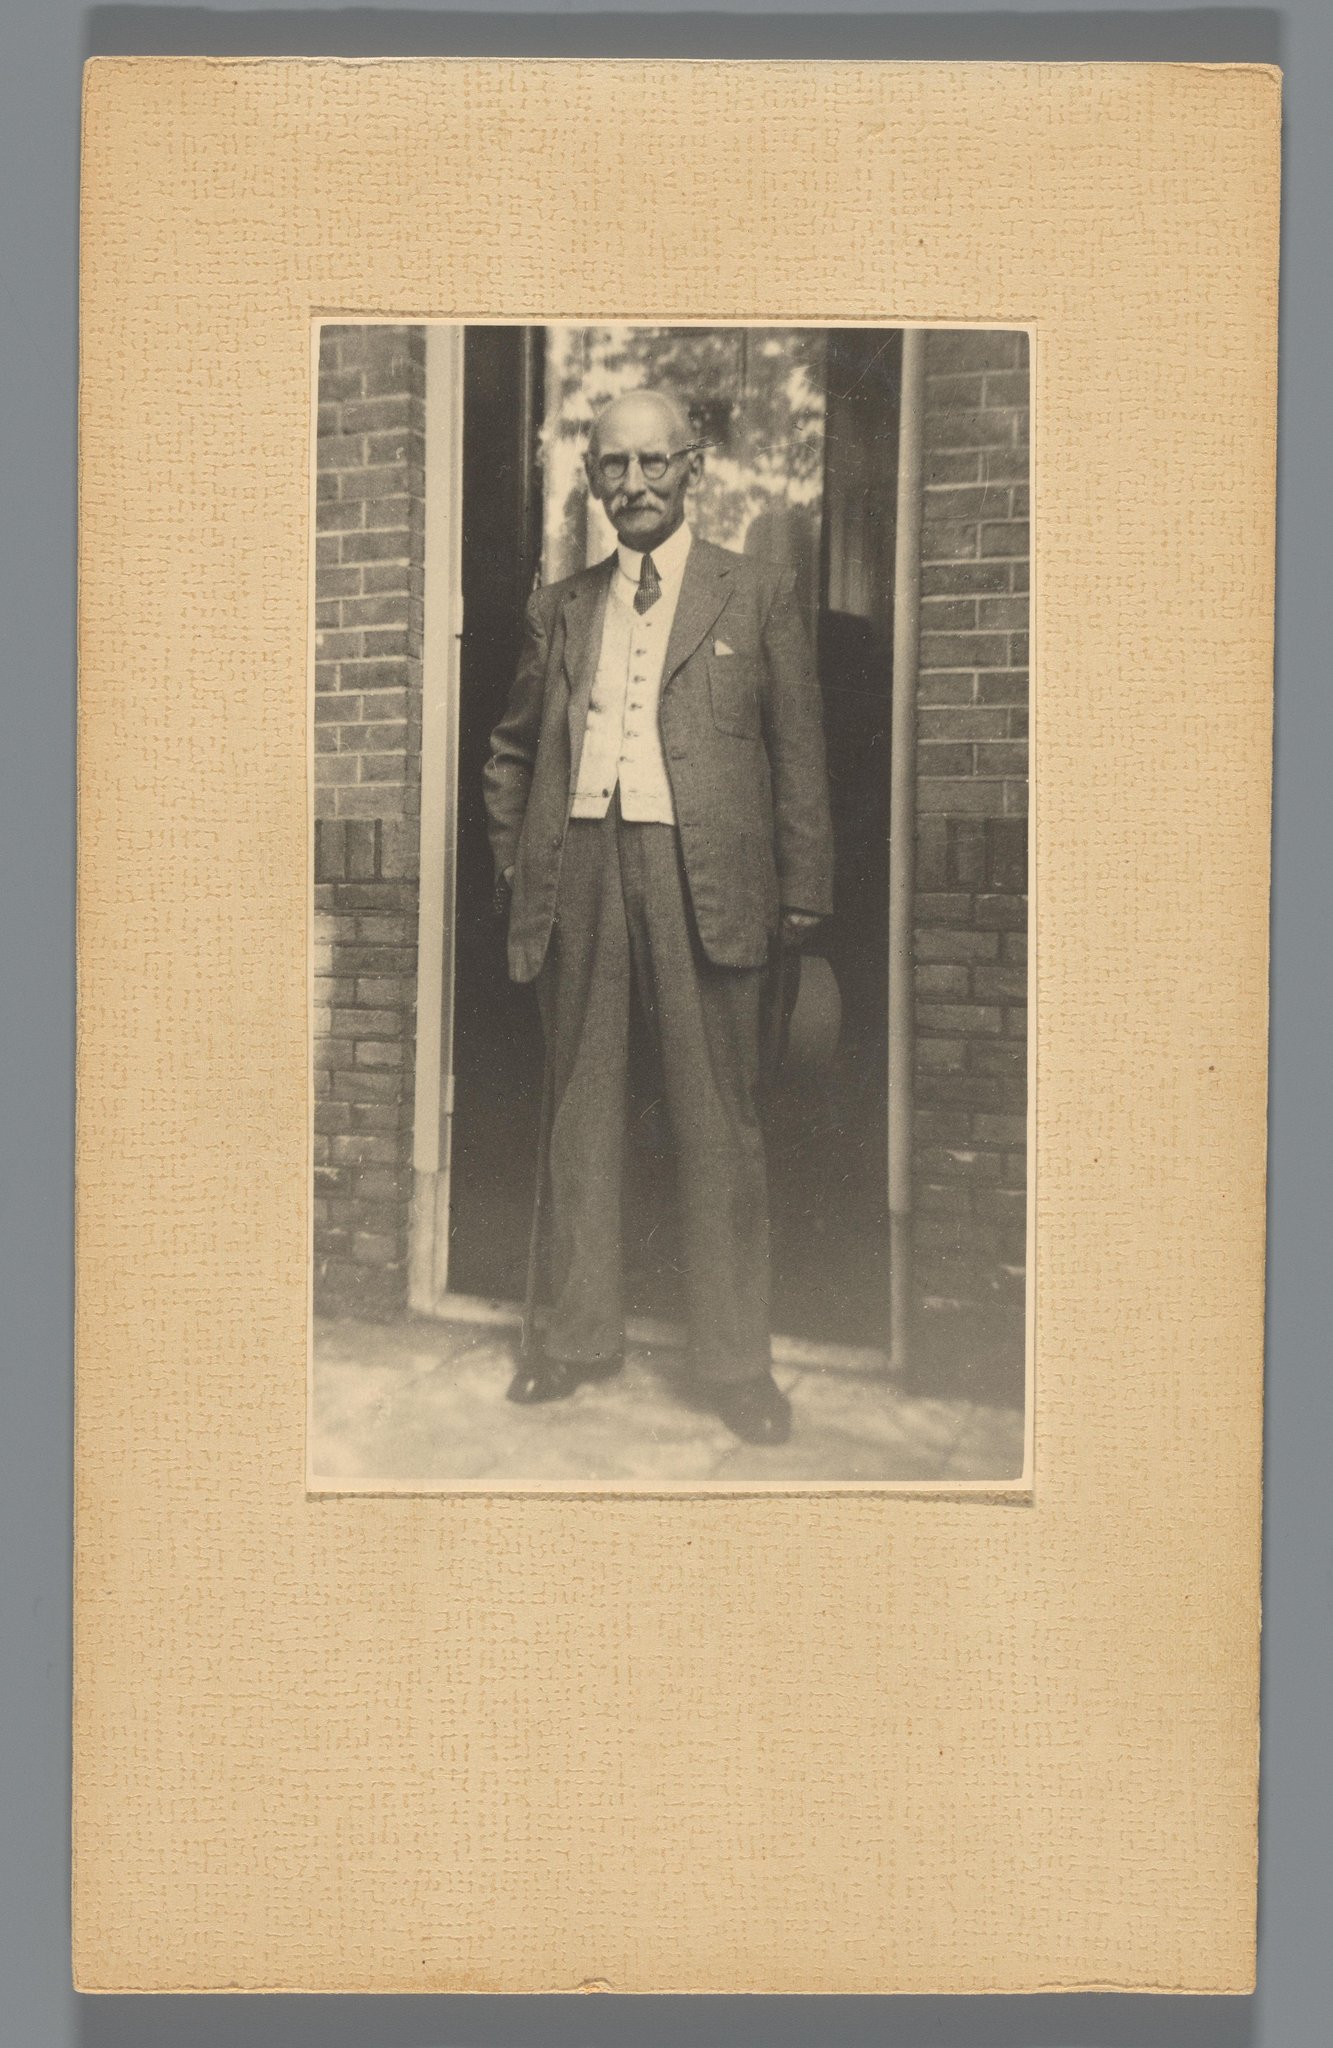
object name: photograph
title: Portret van een onbekende man, mogelijk S.P. Huykens, staande voor een deur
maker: Anonymous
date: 1900-1940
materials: paper, cardboard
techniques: gelatin silver print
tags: historical persons not known by name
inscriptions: inscription: ‘S.P. Huykens [?]/ 10429’